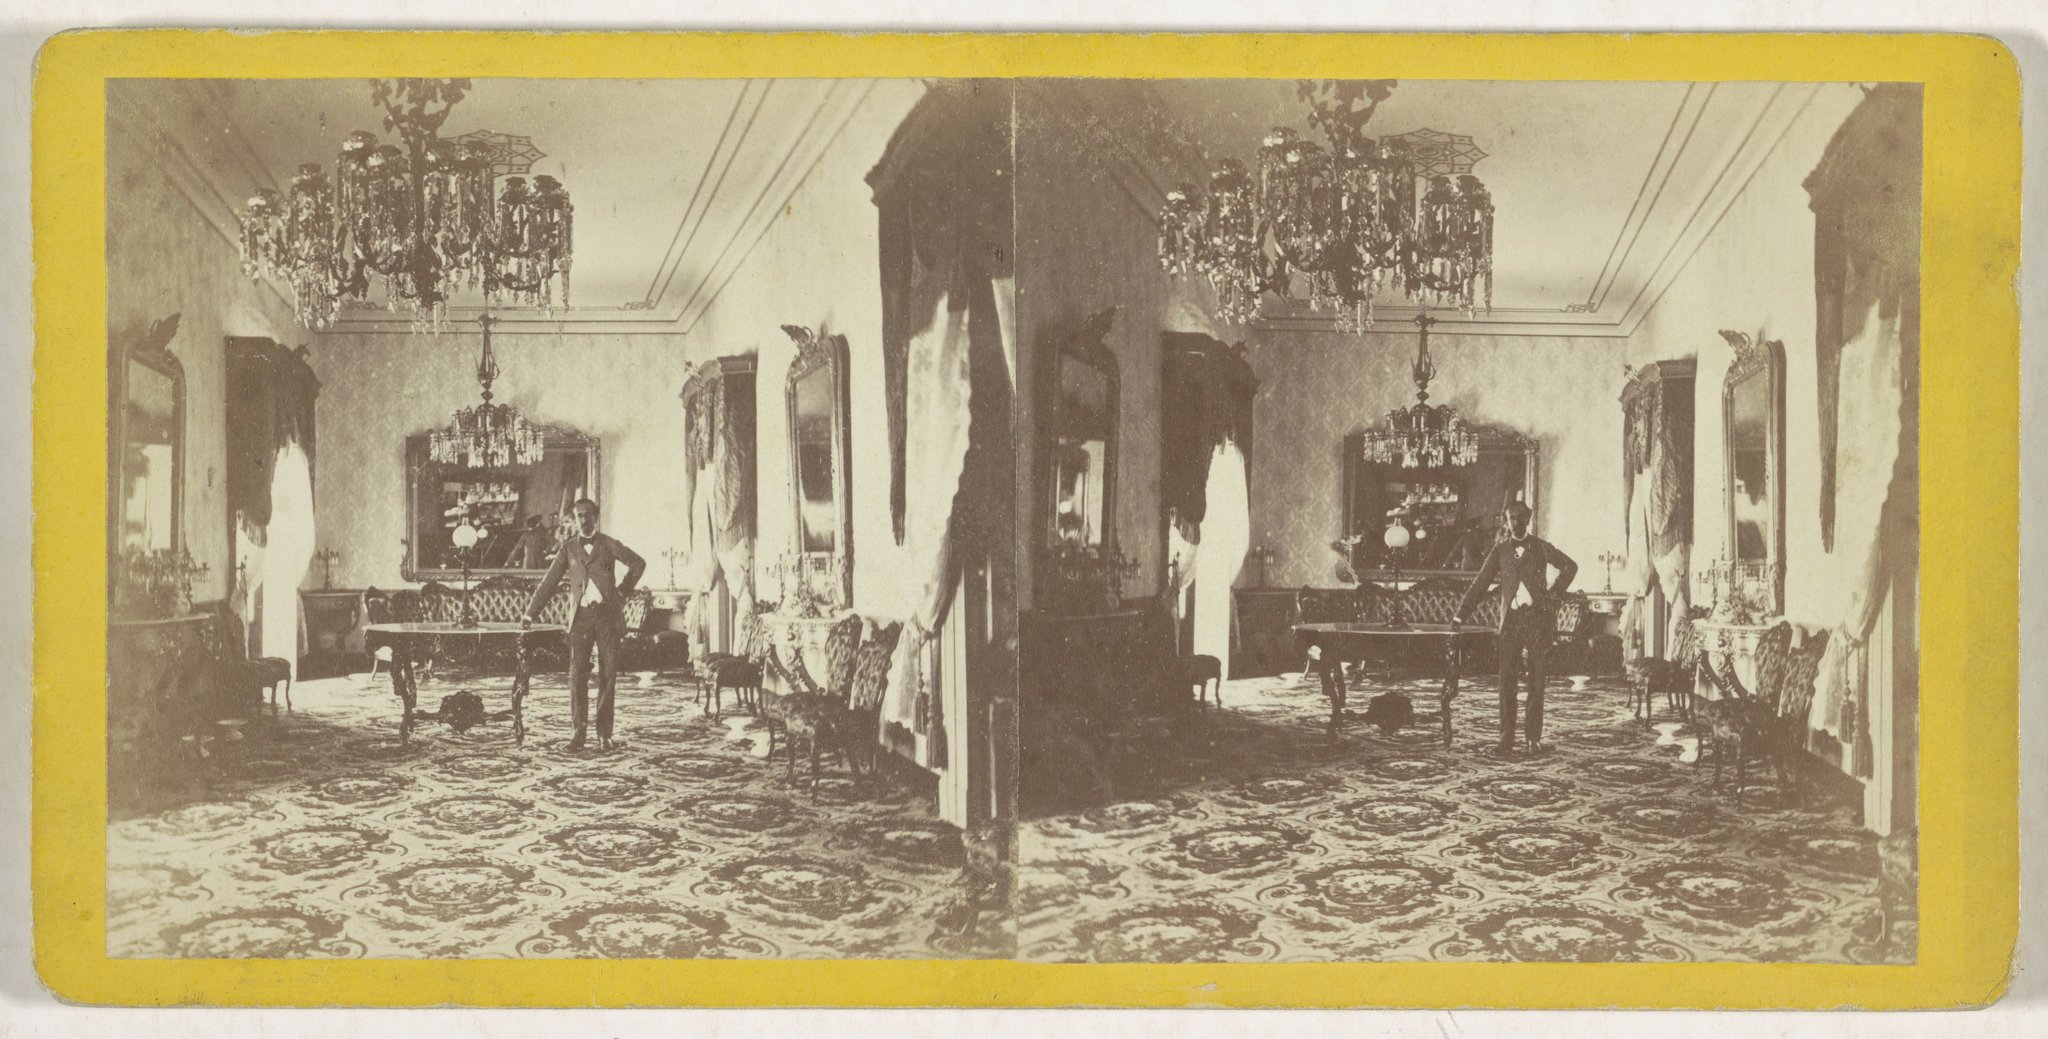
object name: stereograph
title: Vistas de Mejicanas por V. Contreras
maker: vicente contreras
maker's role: fotograaf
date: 1861-1870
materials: cardboard, paper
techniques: albumen print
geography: guanajuato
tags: interior of the house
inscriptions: inscription: ‘Salon finnicipal de Palacio [?]’